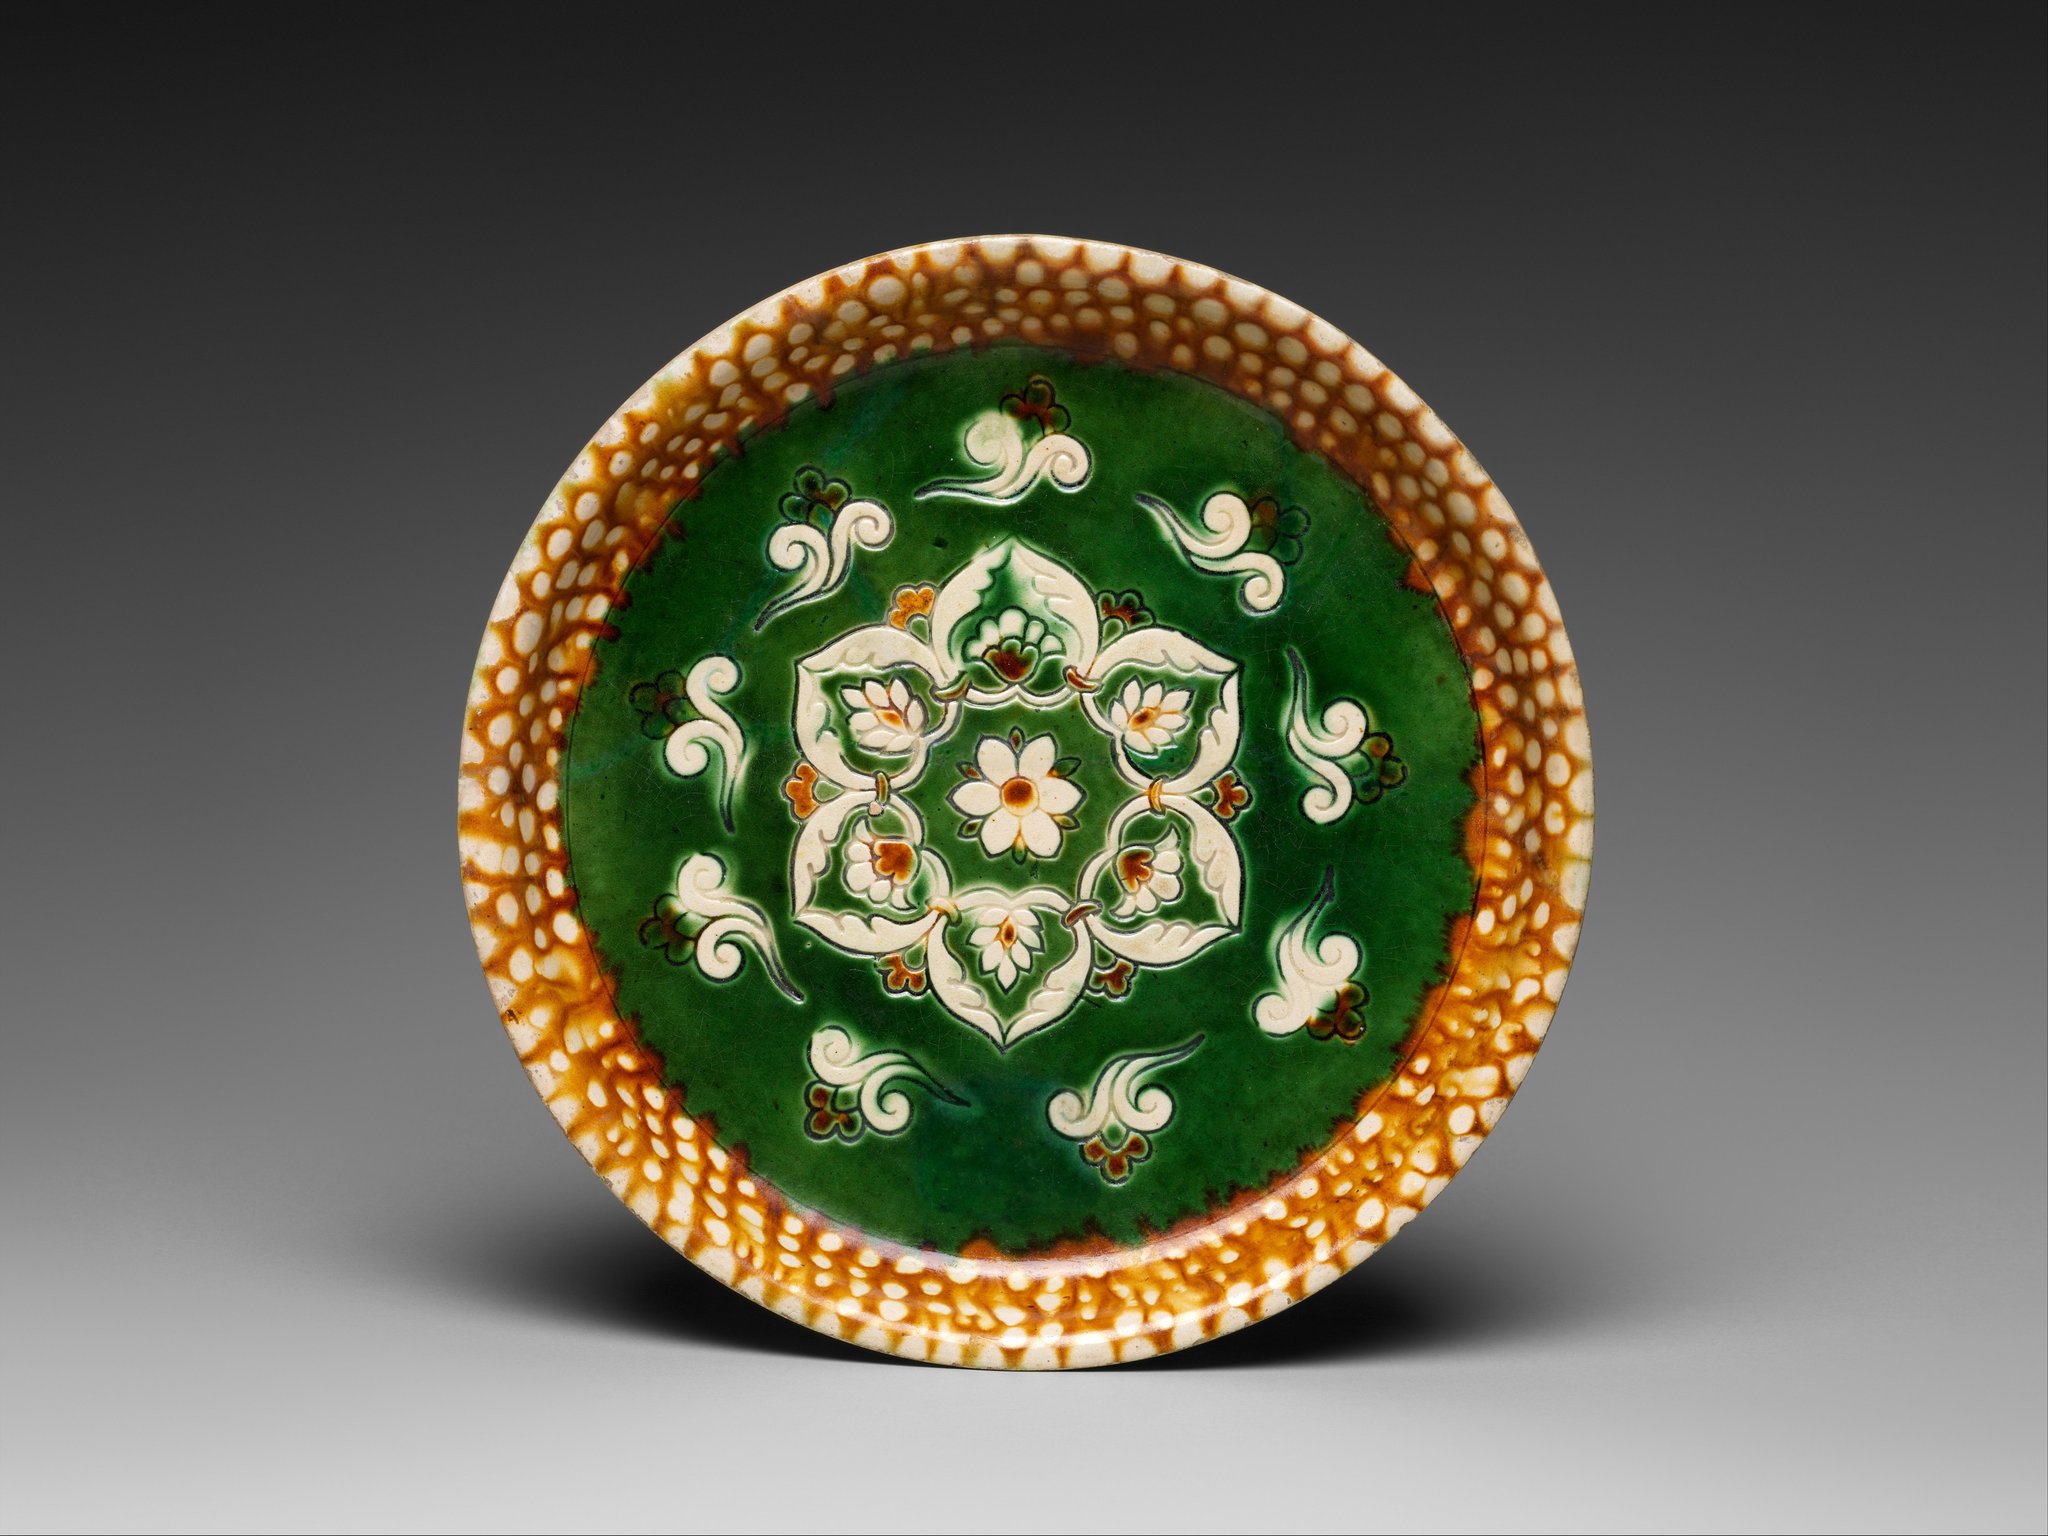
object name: tray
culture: chinese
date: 701-800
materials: earthenware, glaze